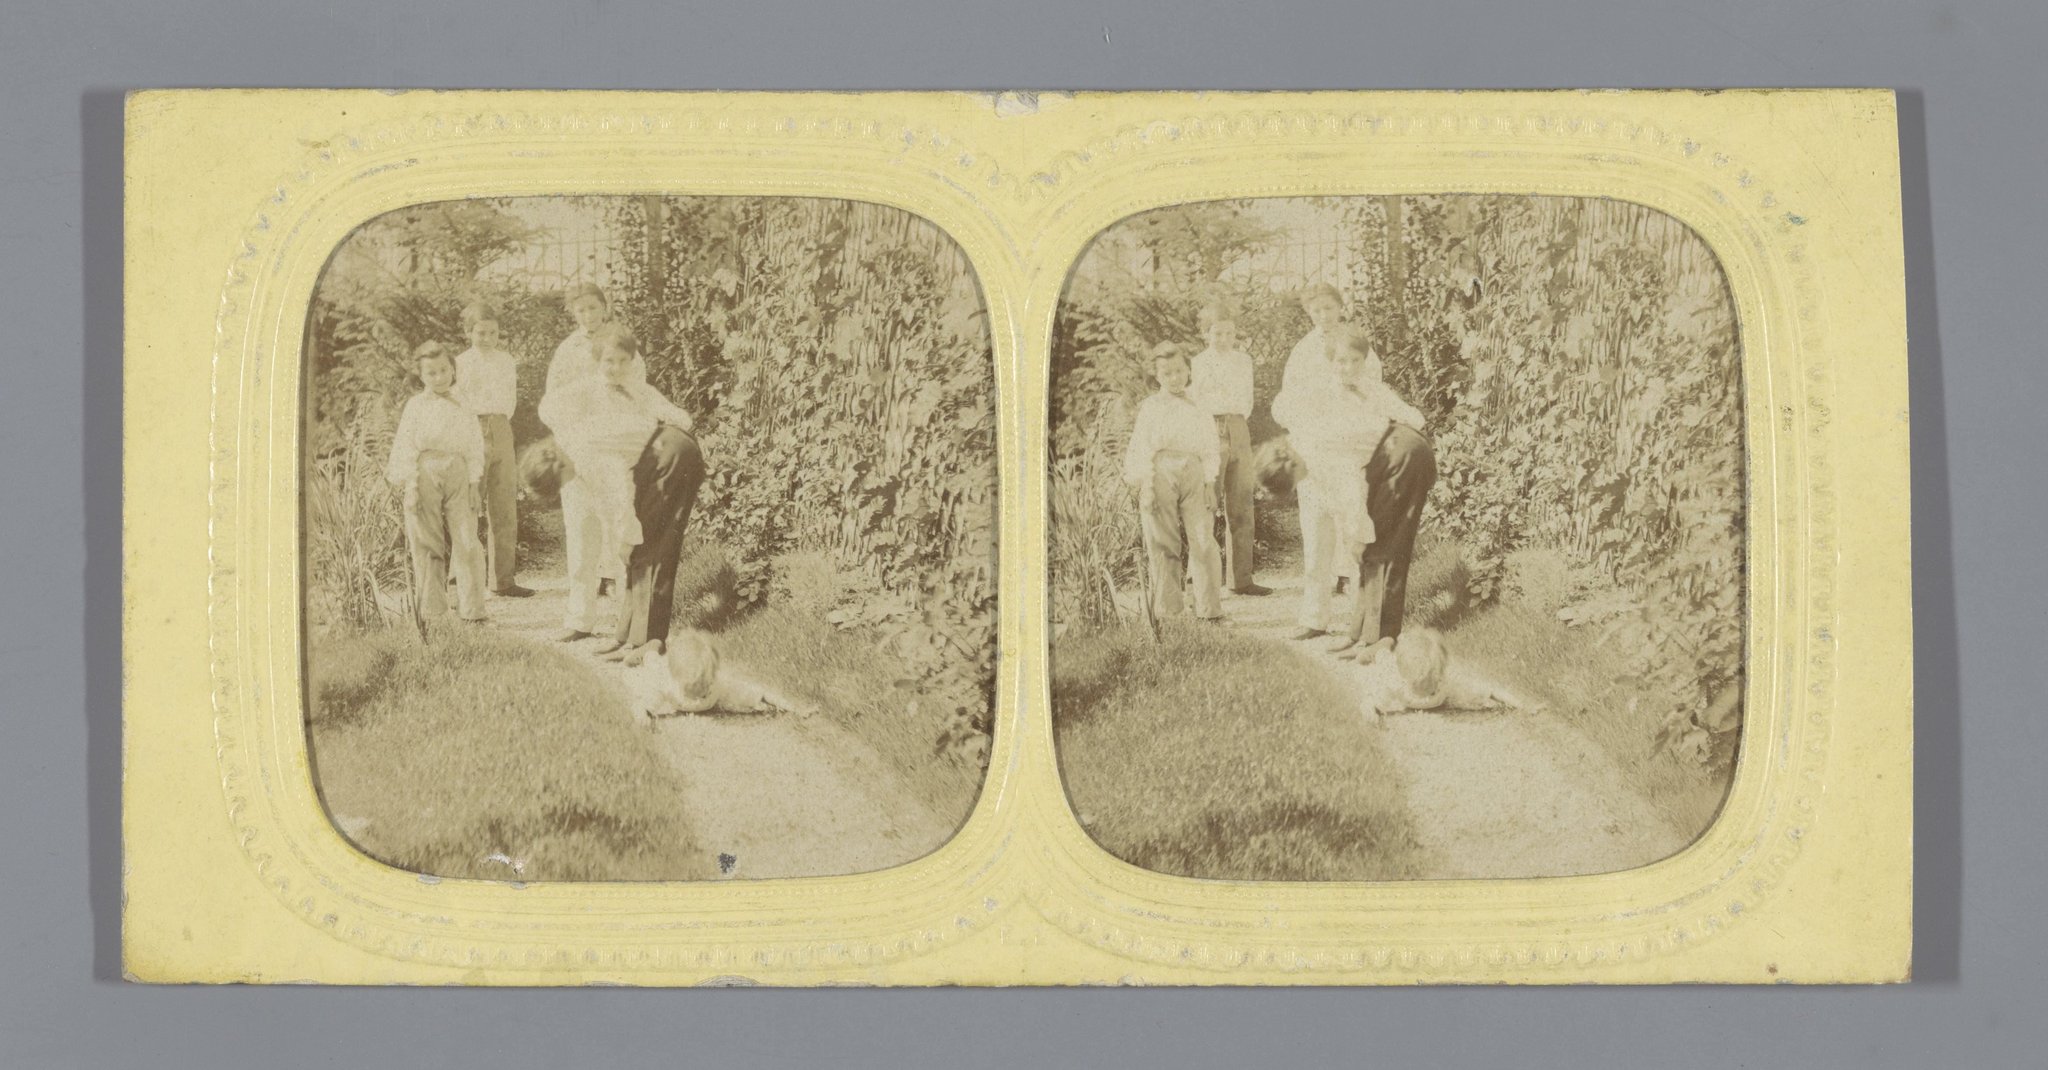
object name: tissue stereograph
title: Zes kinderen spelen haasje over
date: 1855-1875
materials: cardboard, paper, photographic support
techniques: albumen print, hand coloring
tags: other children's games